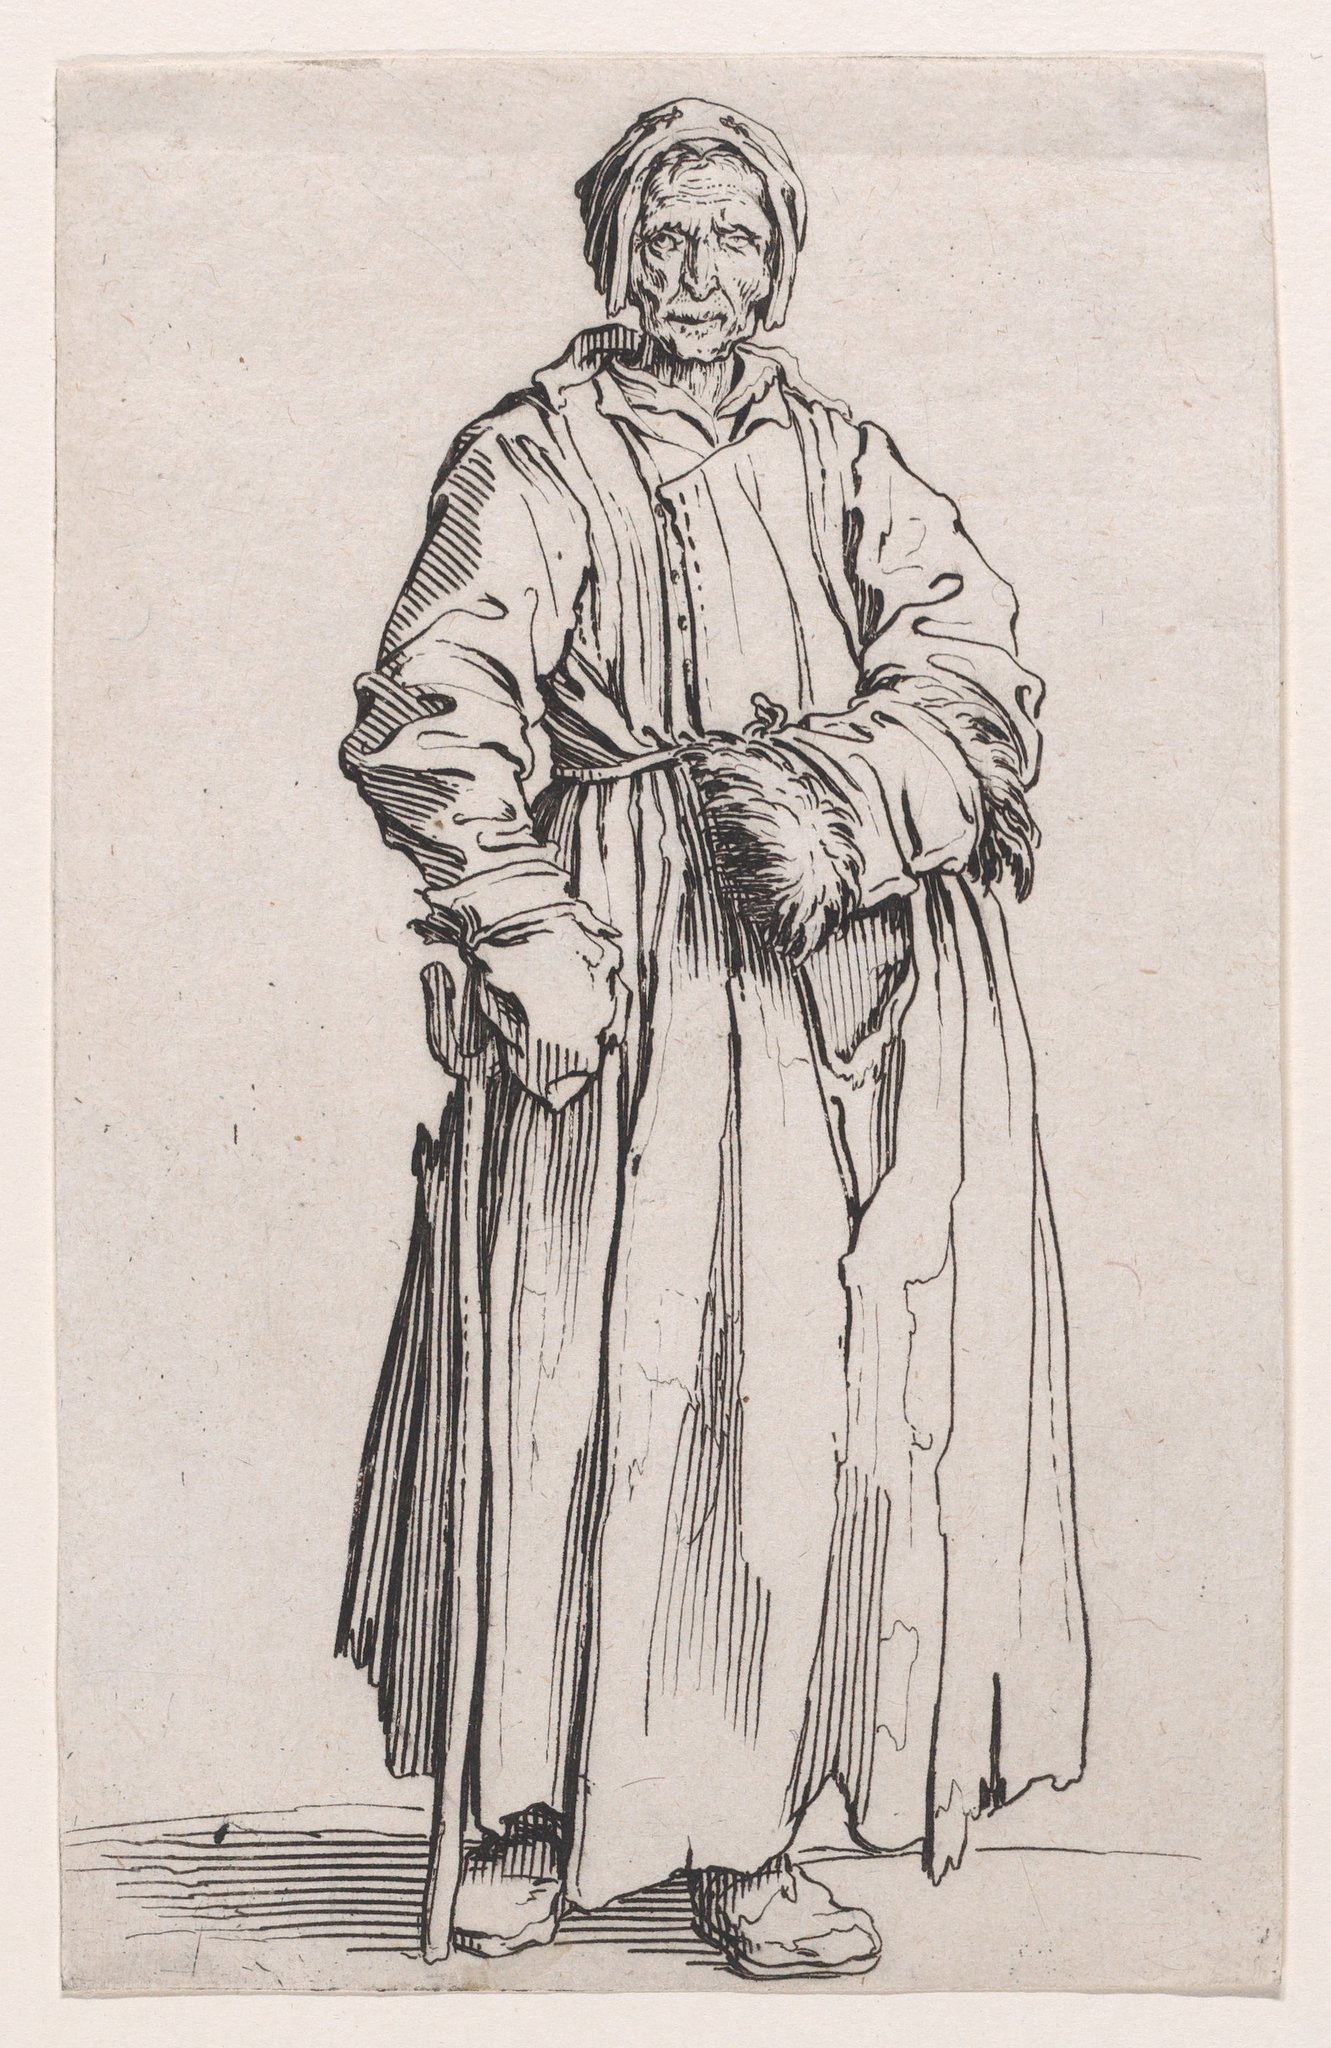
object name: print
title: La Borgnesse (The Woman with One Eye), from "Les Gueux suite appelée aussi Les Mendiants, Les Baroni, ou Les Barons" (The Beggars, also called the Barons)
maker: jacques callot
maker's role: artist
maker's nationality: french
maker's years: 1592-1635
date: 1623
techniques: etching